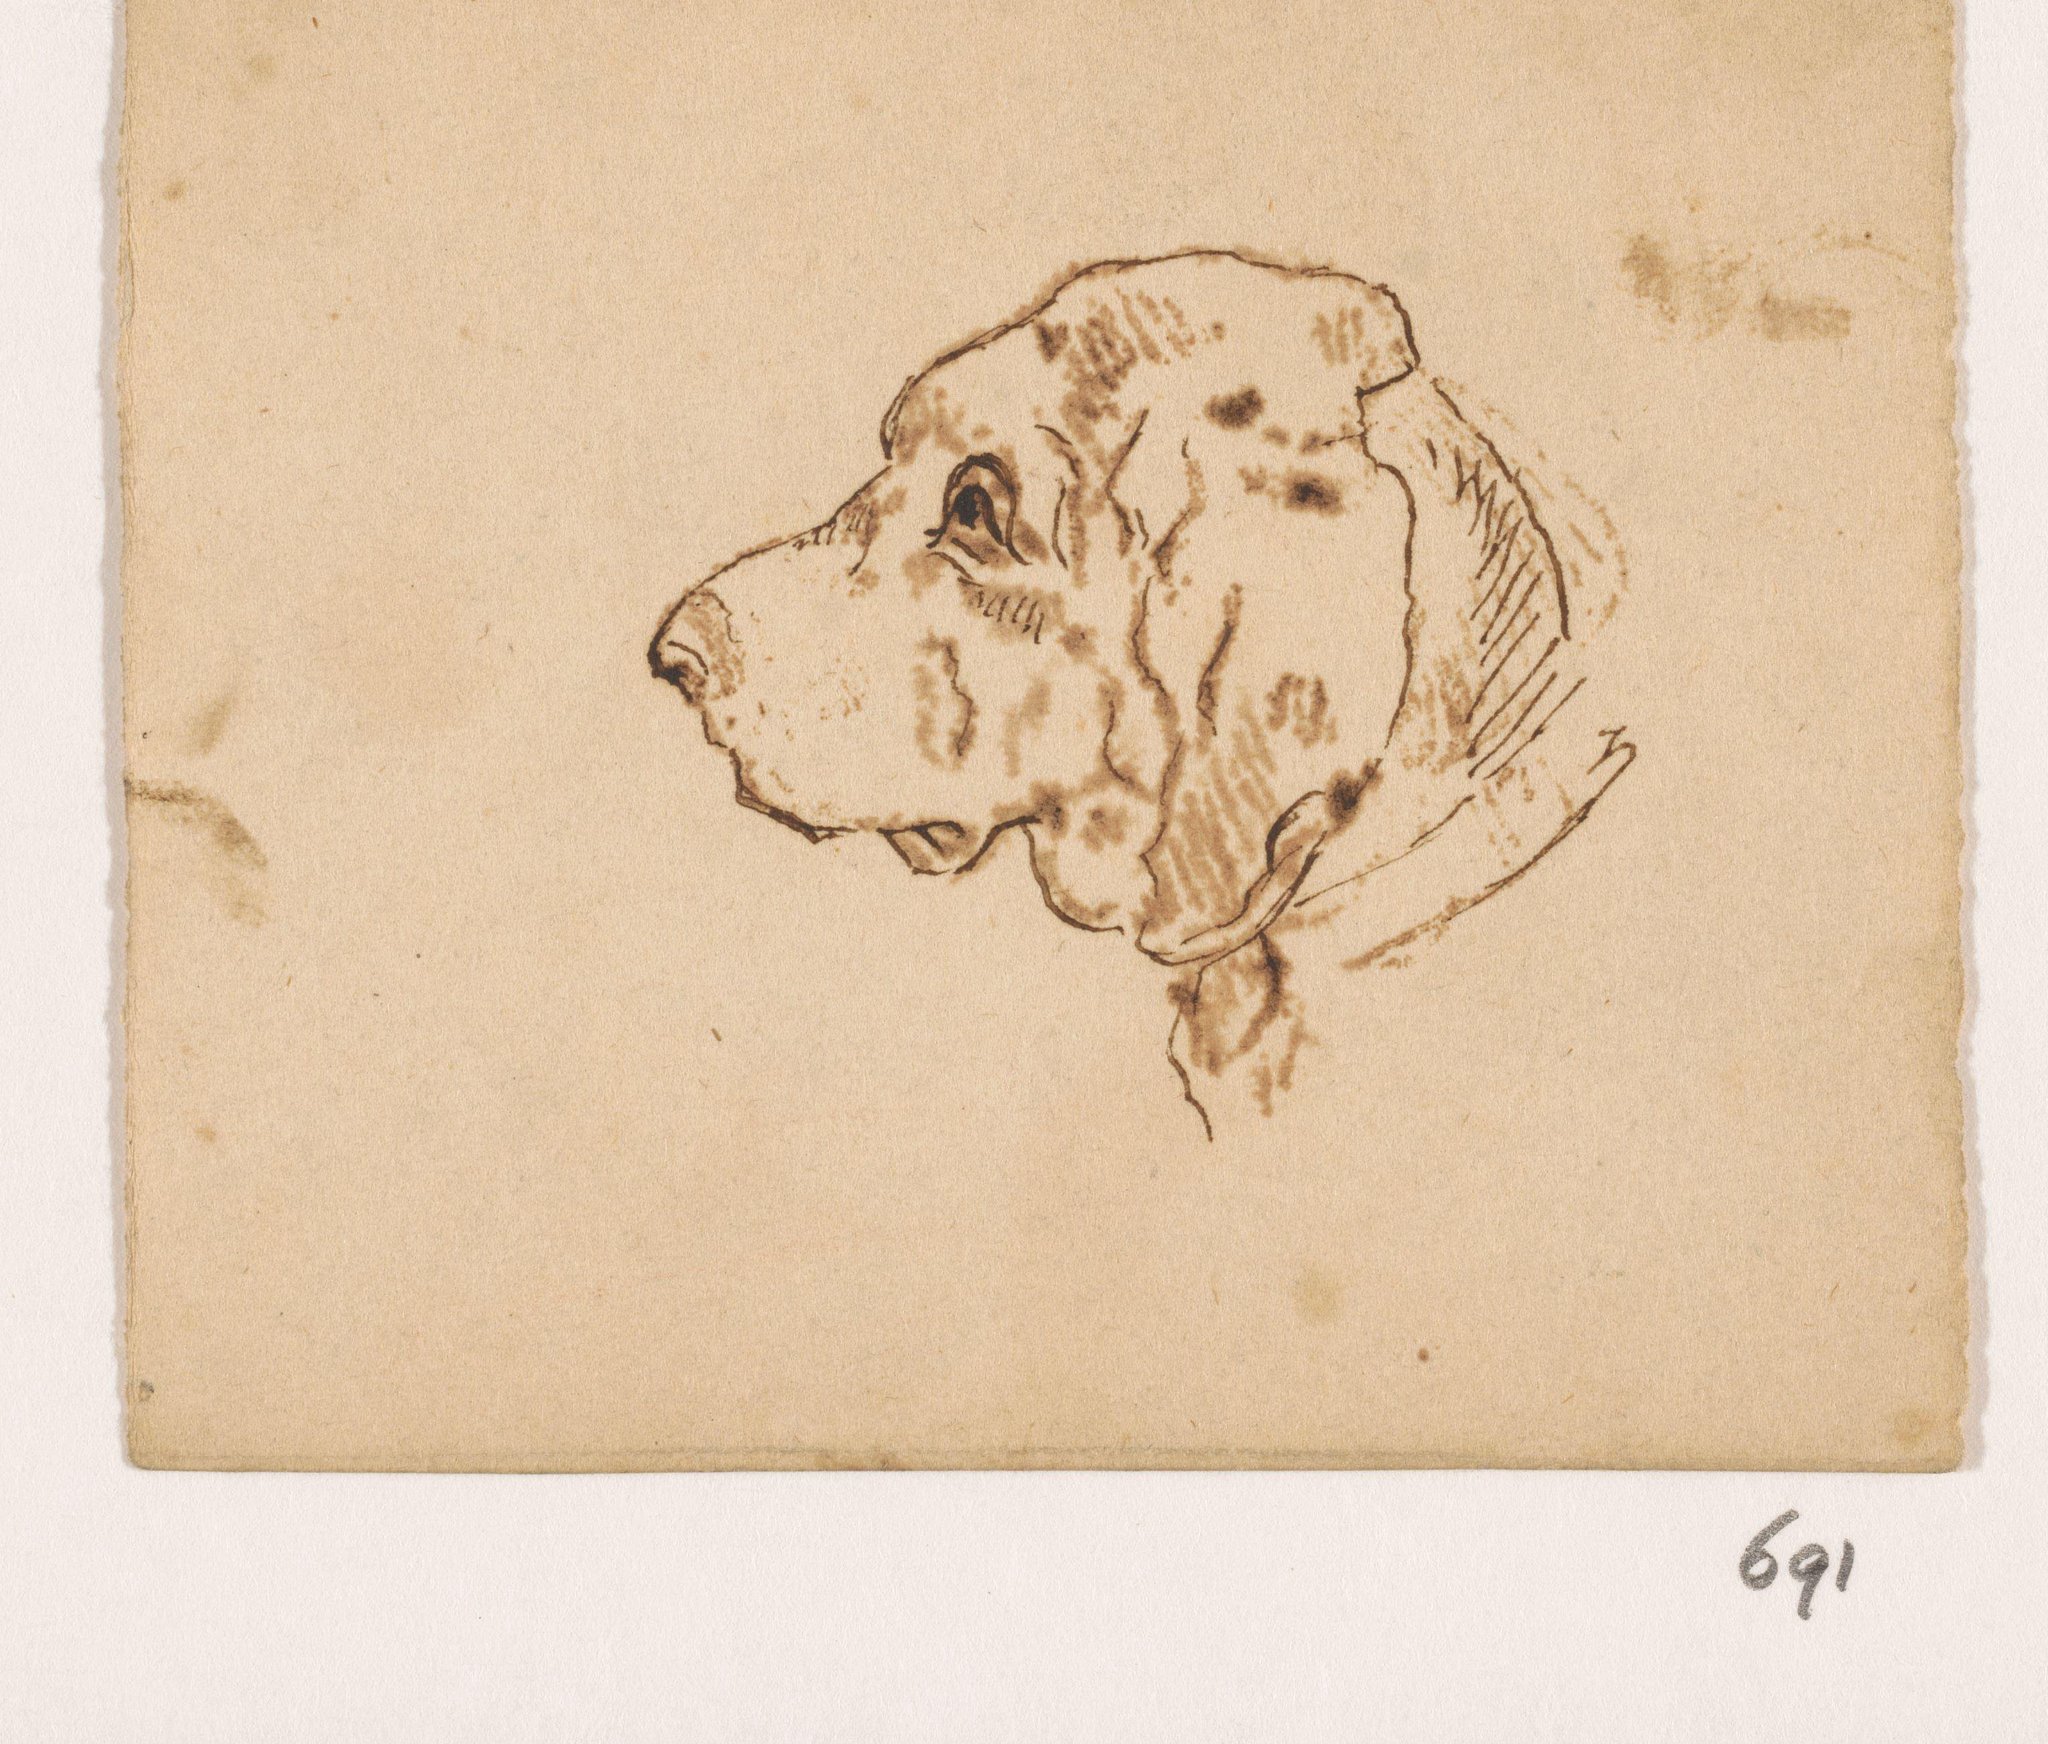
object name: drawing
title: Kop van een jachthond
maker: johannes tavenraat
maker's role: draughtsman, painter, print maker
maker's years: 1809-1881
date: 1840-1880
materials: ink, paper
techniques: pen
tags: hunting dogs, dog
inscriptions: collector's mark: Lugt 2228